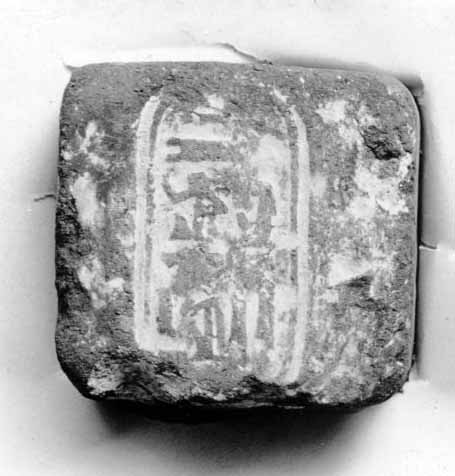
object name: cone, aye, oval stamp, rectangular cone, chief of servant, amun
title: Funerary Cone of the Chief of the Servants of Amun Aye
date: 1550-1295 BCE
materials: pottery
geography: egypt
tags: hieroglyphs